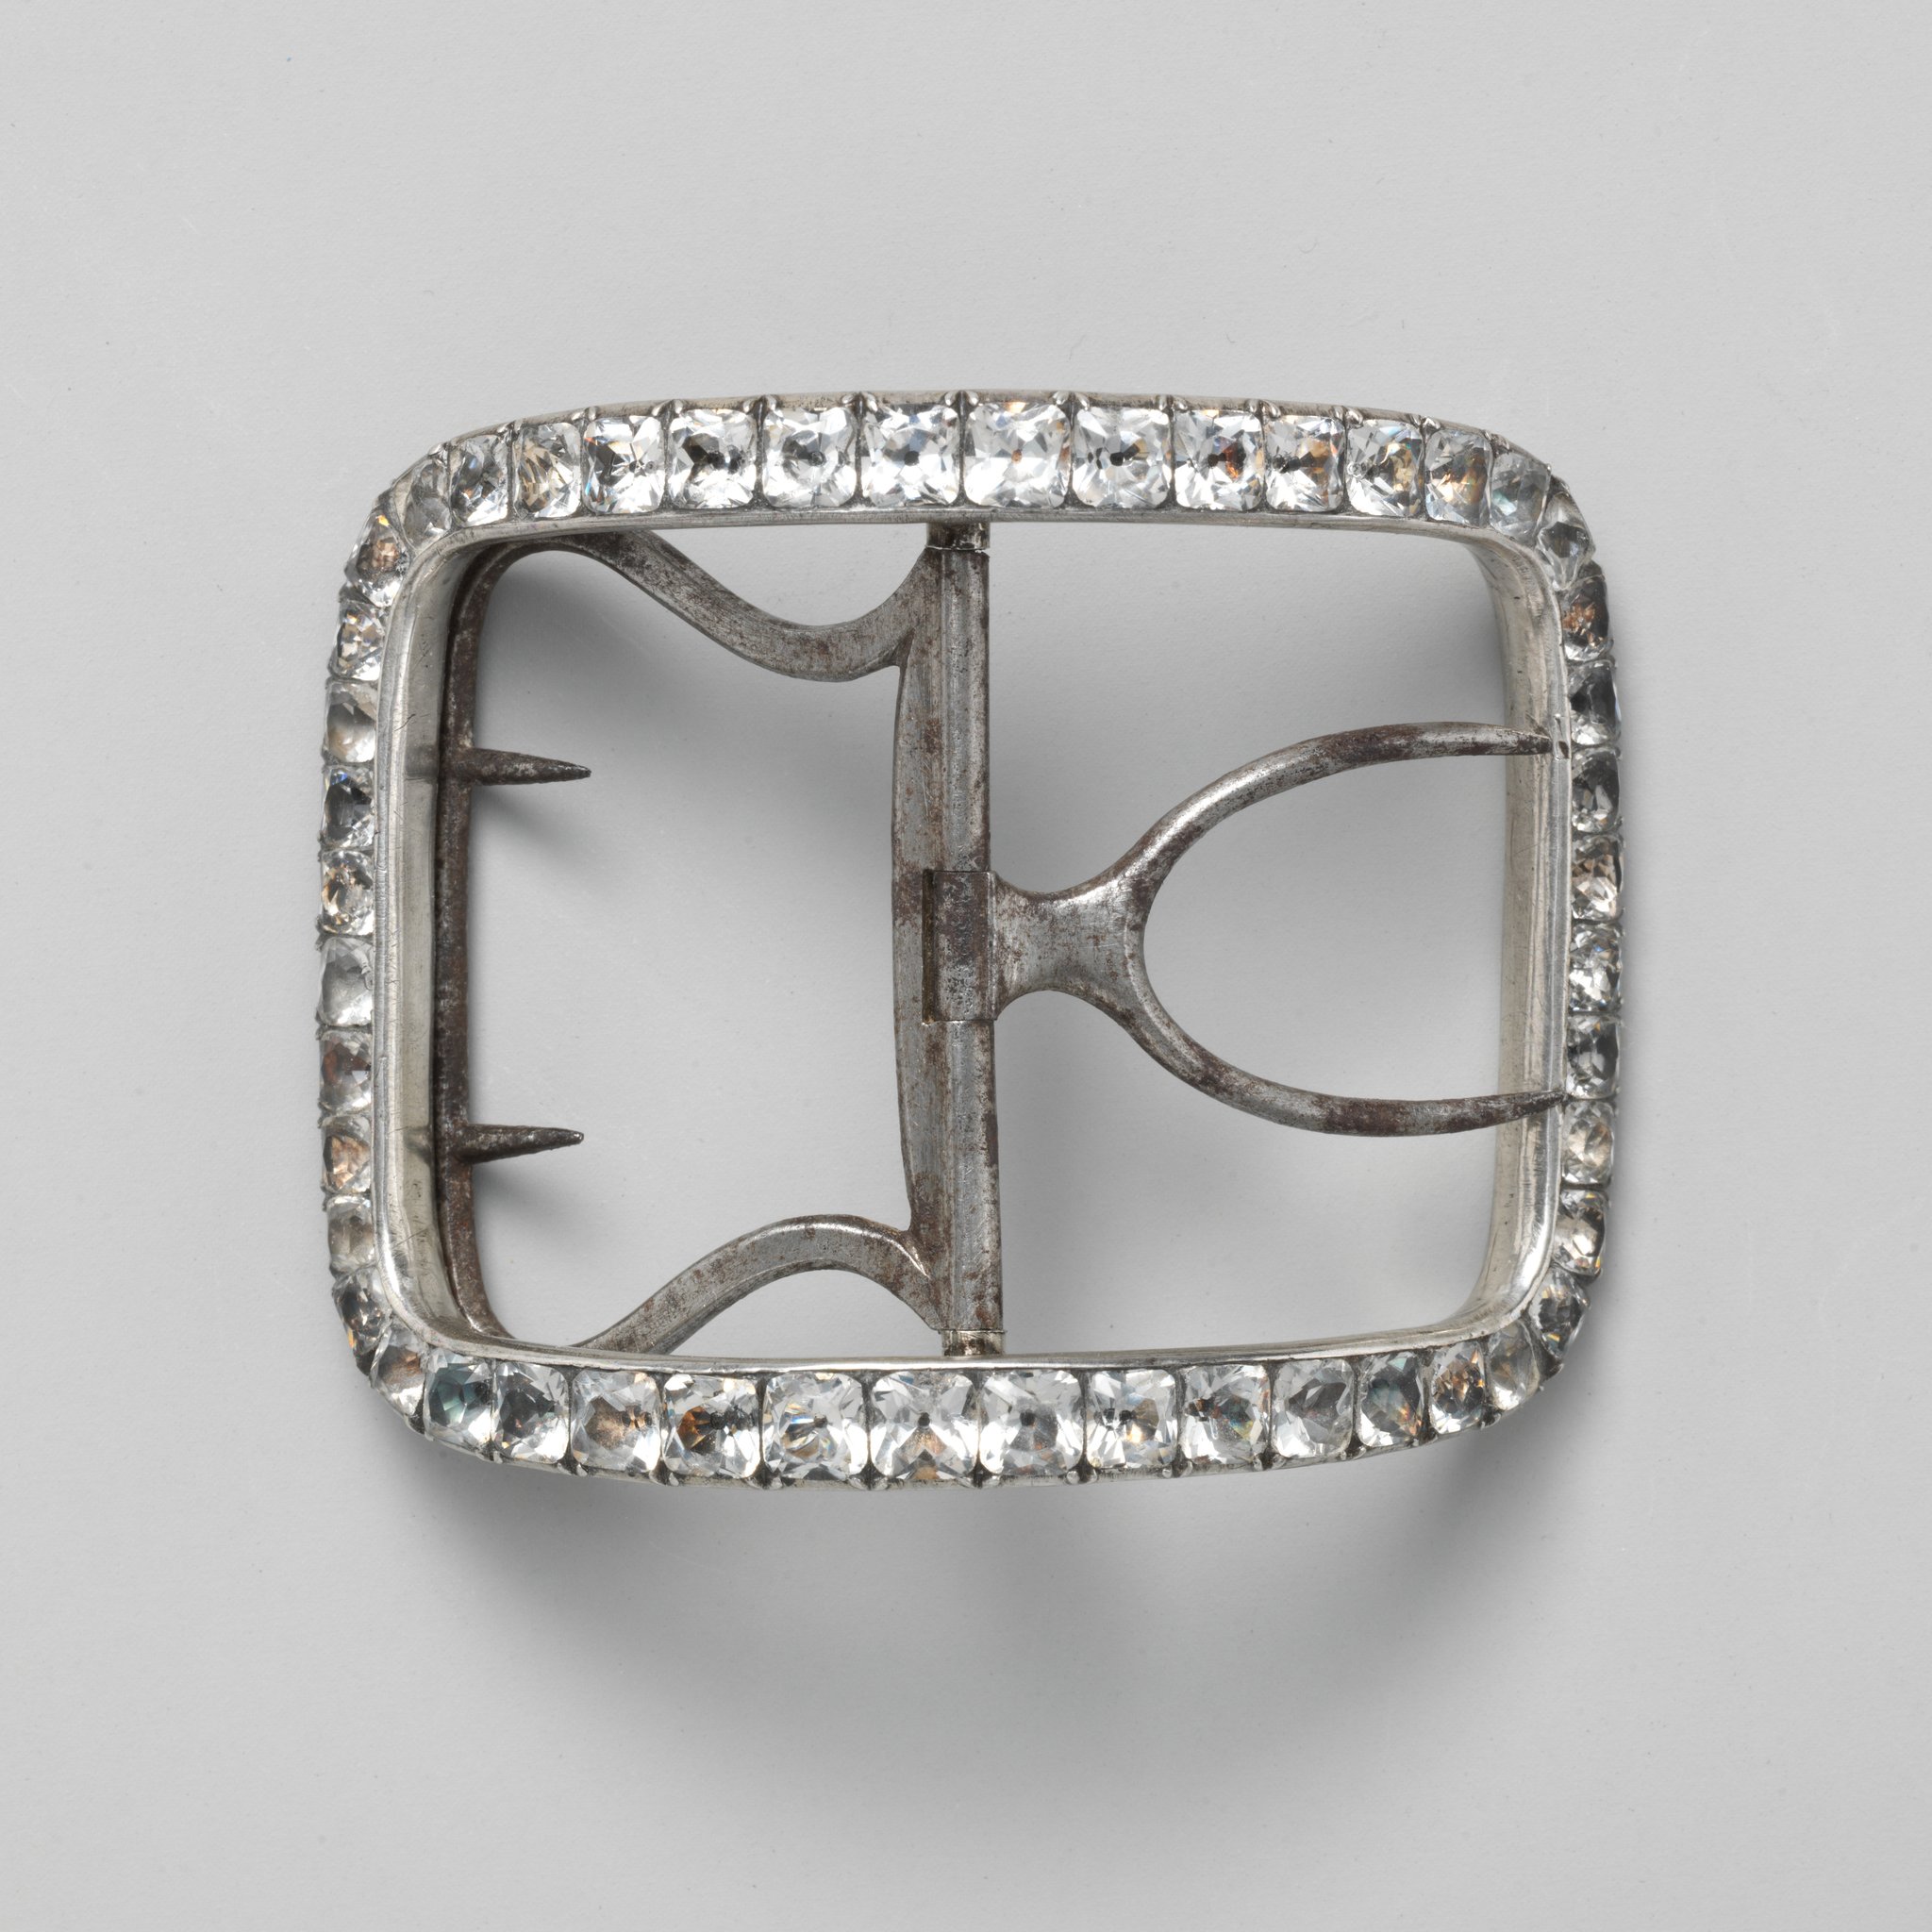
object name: shoe buckle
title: Shoe buckles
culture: british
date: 1767-1800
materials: metal, paste